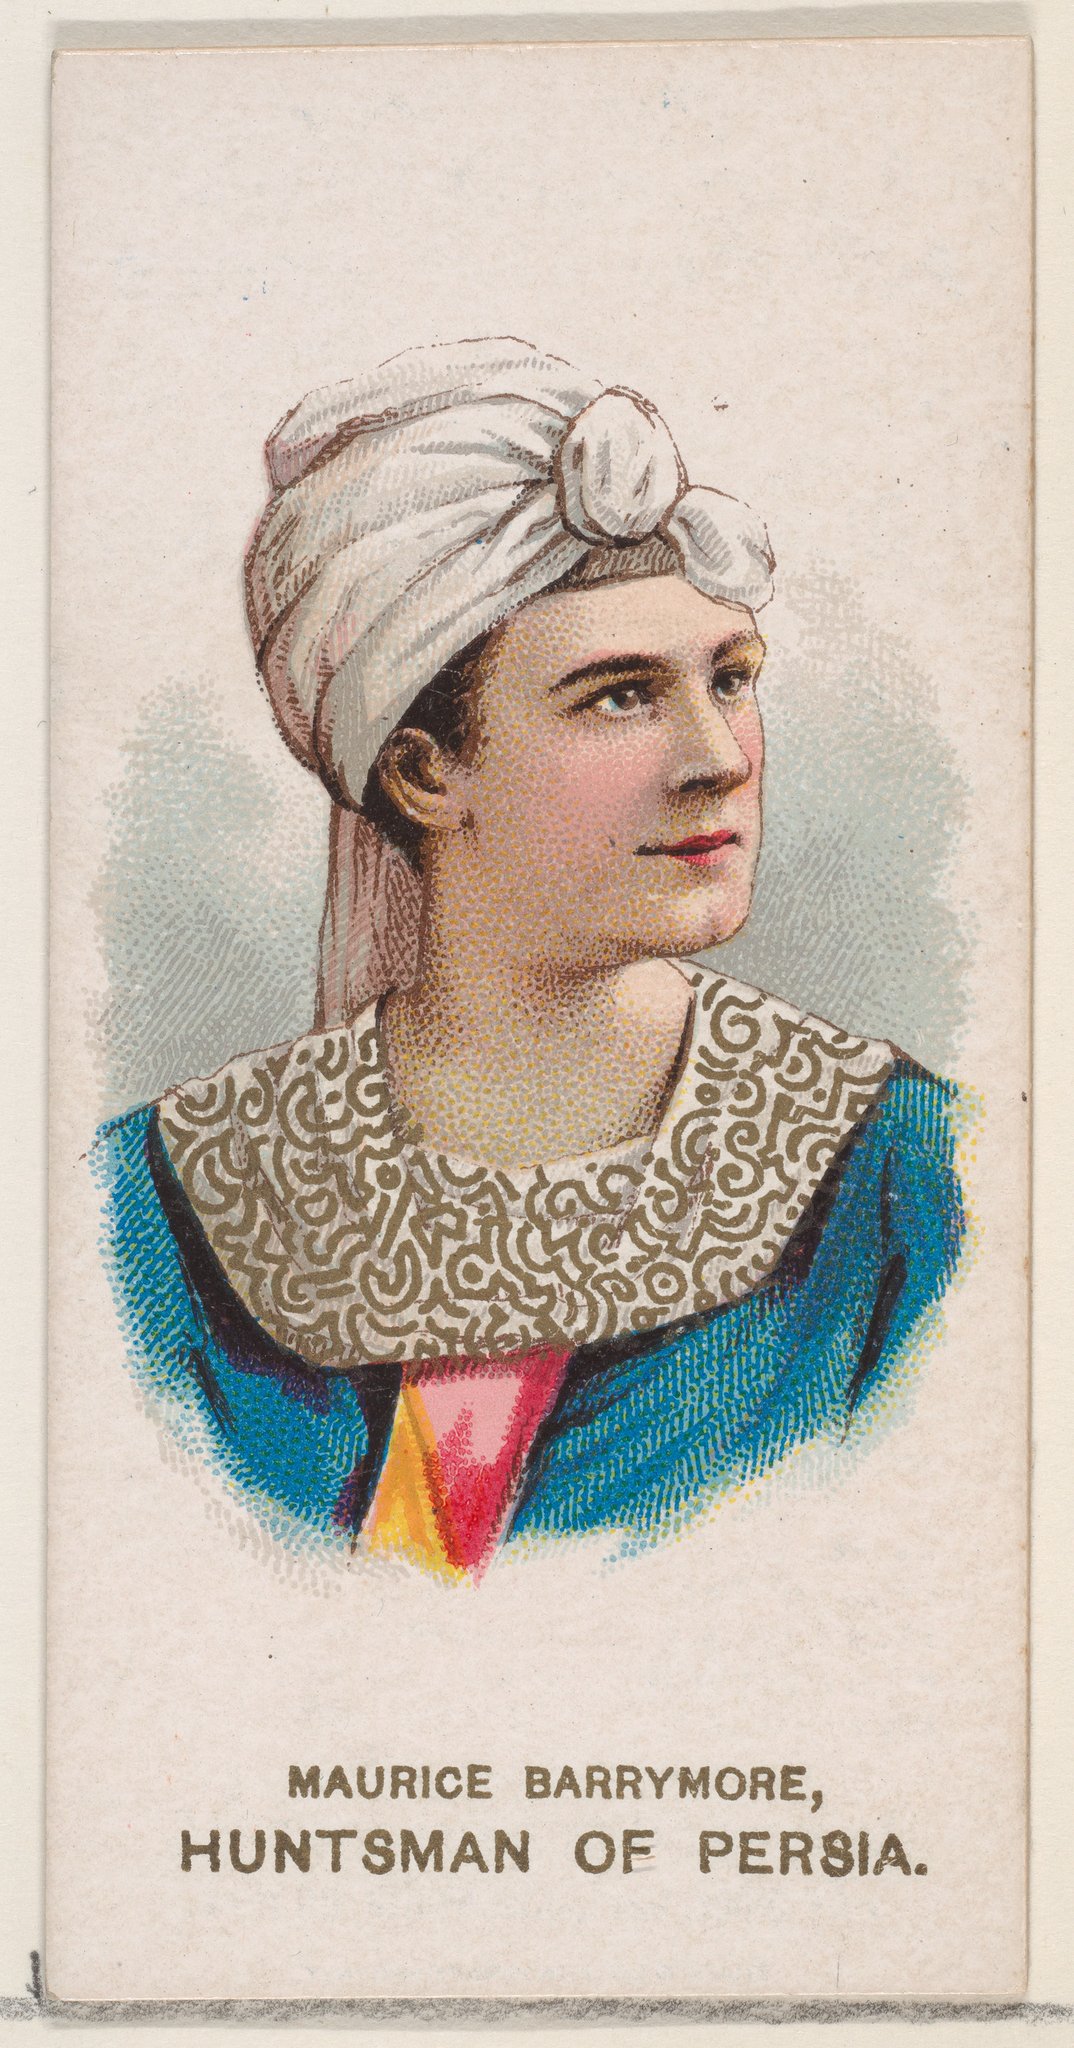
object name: print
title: Maurice Barrymore as a Huntsman of Persia, from the set Actors and Actresses, Second Series (N71) for Duke brand cigarettes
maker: w. duke, sons & co.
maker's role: publisher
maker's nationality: american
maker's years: 1870-1920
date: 1888-1890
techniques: color lithograph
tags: women,actresses